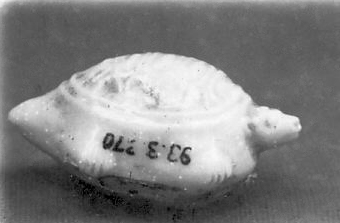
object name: ornament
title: Ornament in the Form of a Tortoise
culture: japanese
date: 1800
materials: porcelain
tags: animals